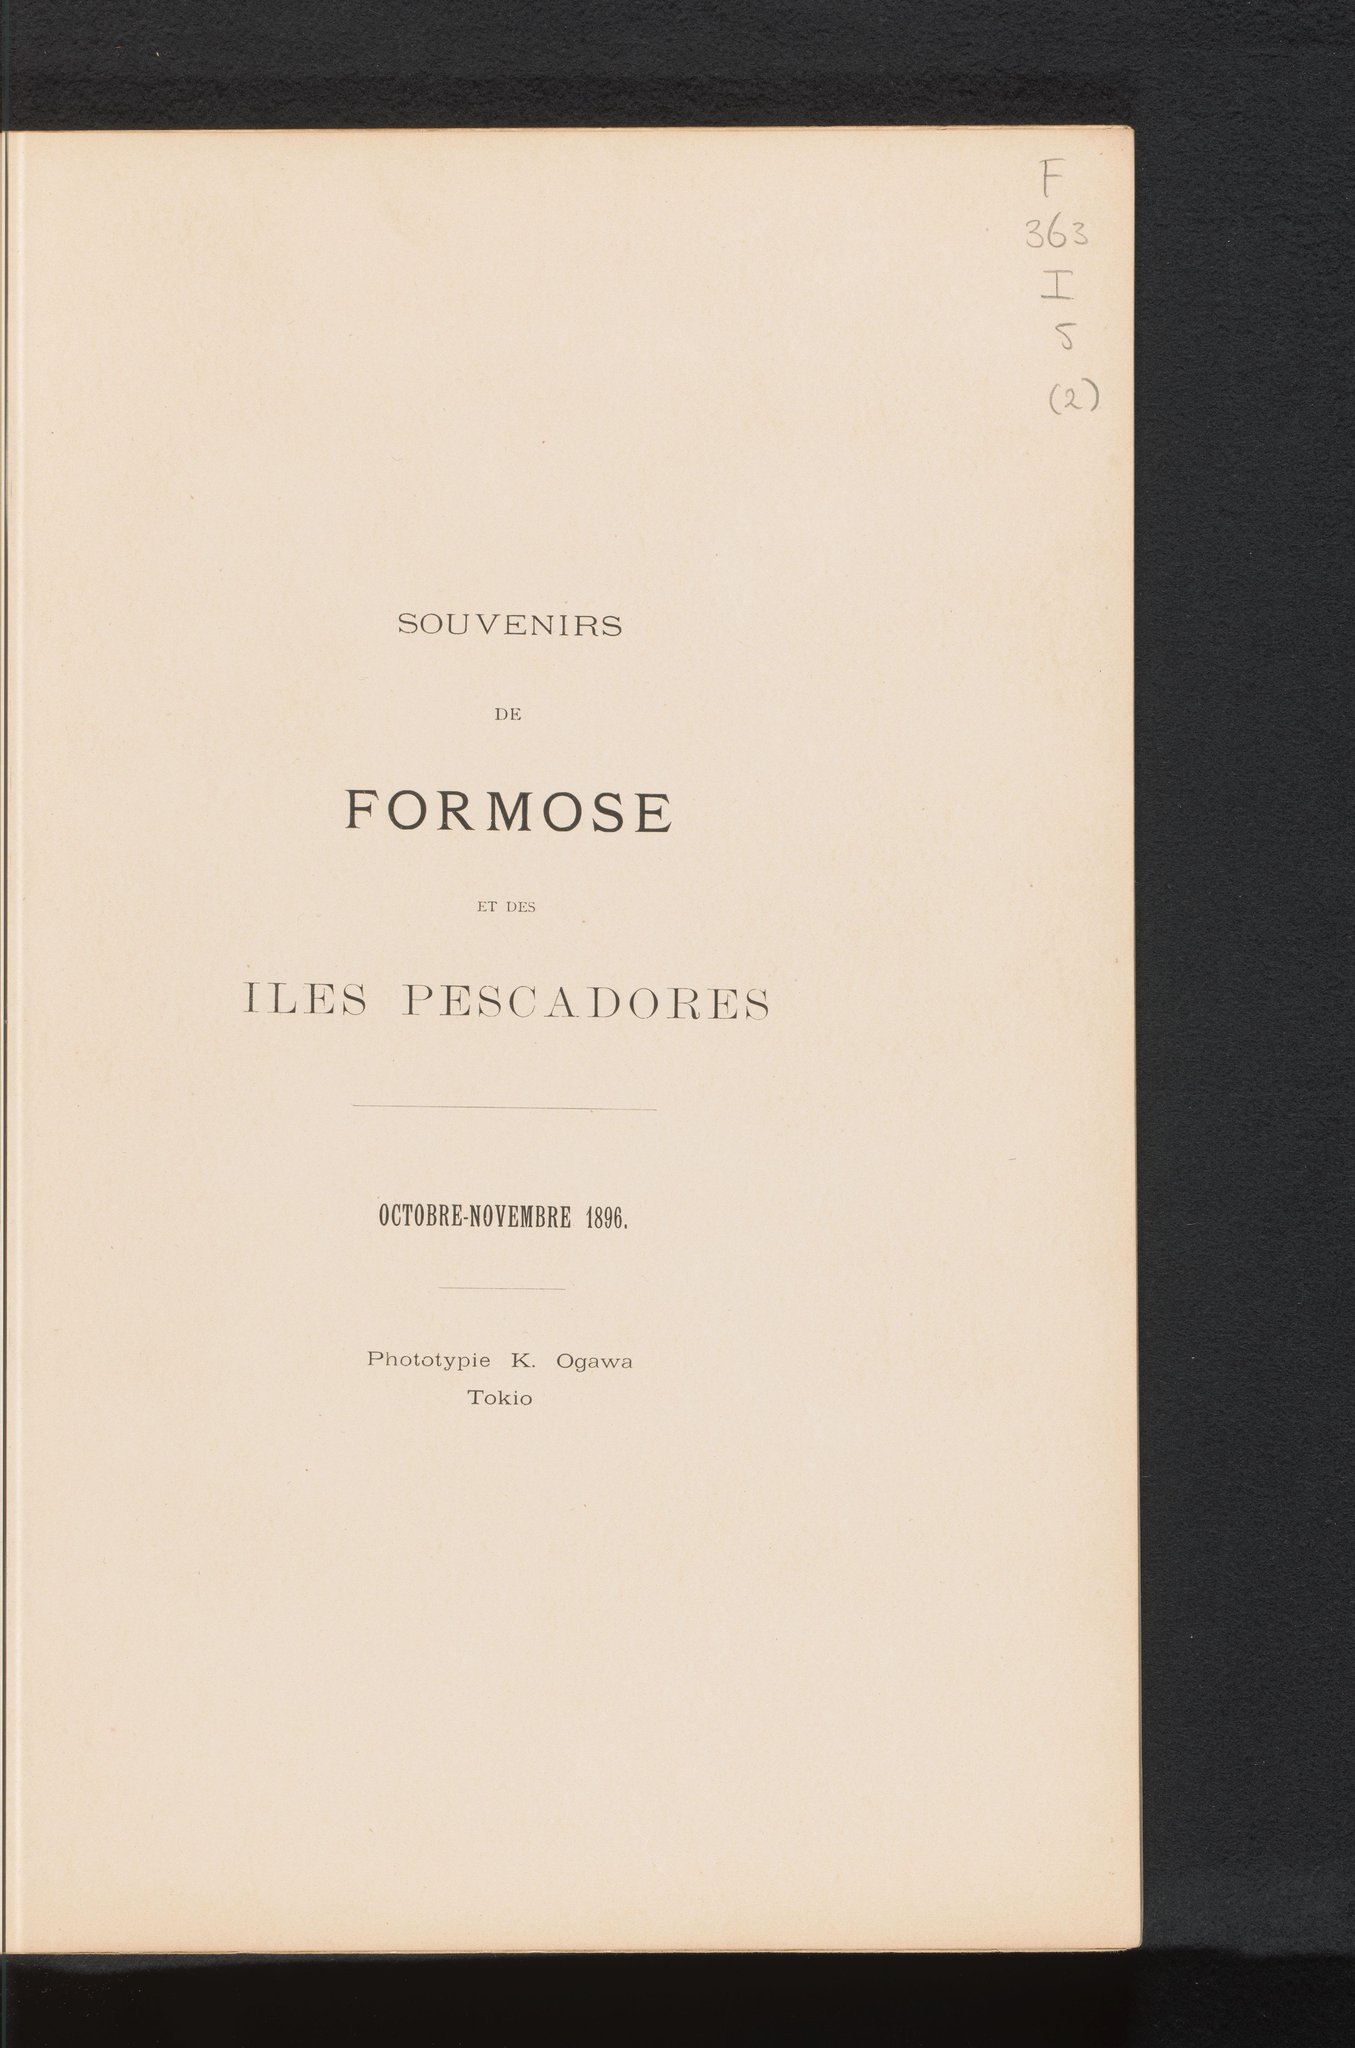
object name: book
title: Souvenirs de Formose et des Iles Pescadores : octobre-novembre 1896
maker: kazumasa ogawa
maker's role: auteur, fotograaf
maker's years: 1860-1929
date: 1896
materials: cardboard, linen, paper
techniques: photograph, decorated paper, printing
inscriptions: annotation: ‘76/4251 1+1’, date: ‘NOV 1989’